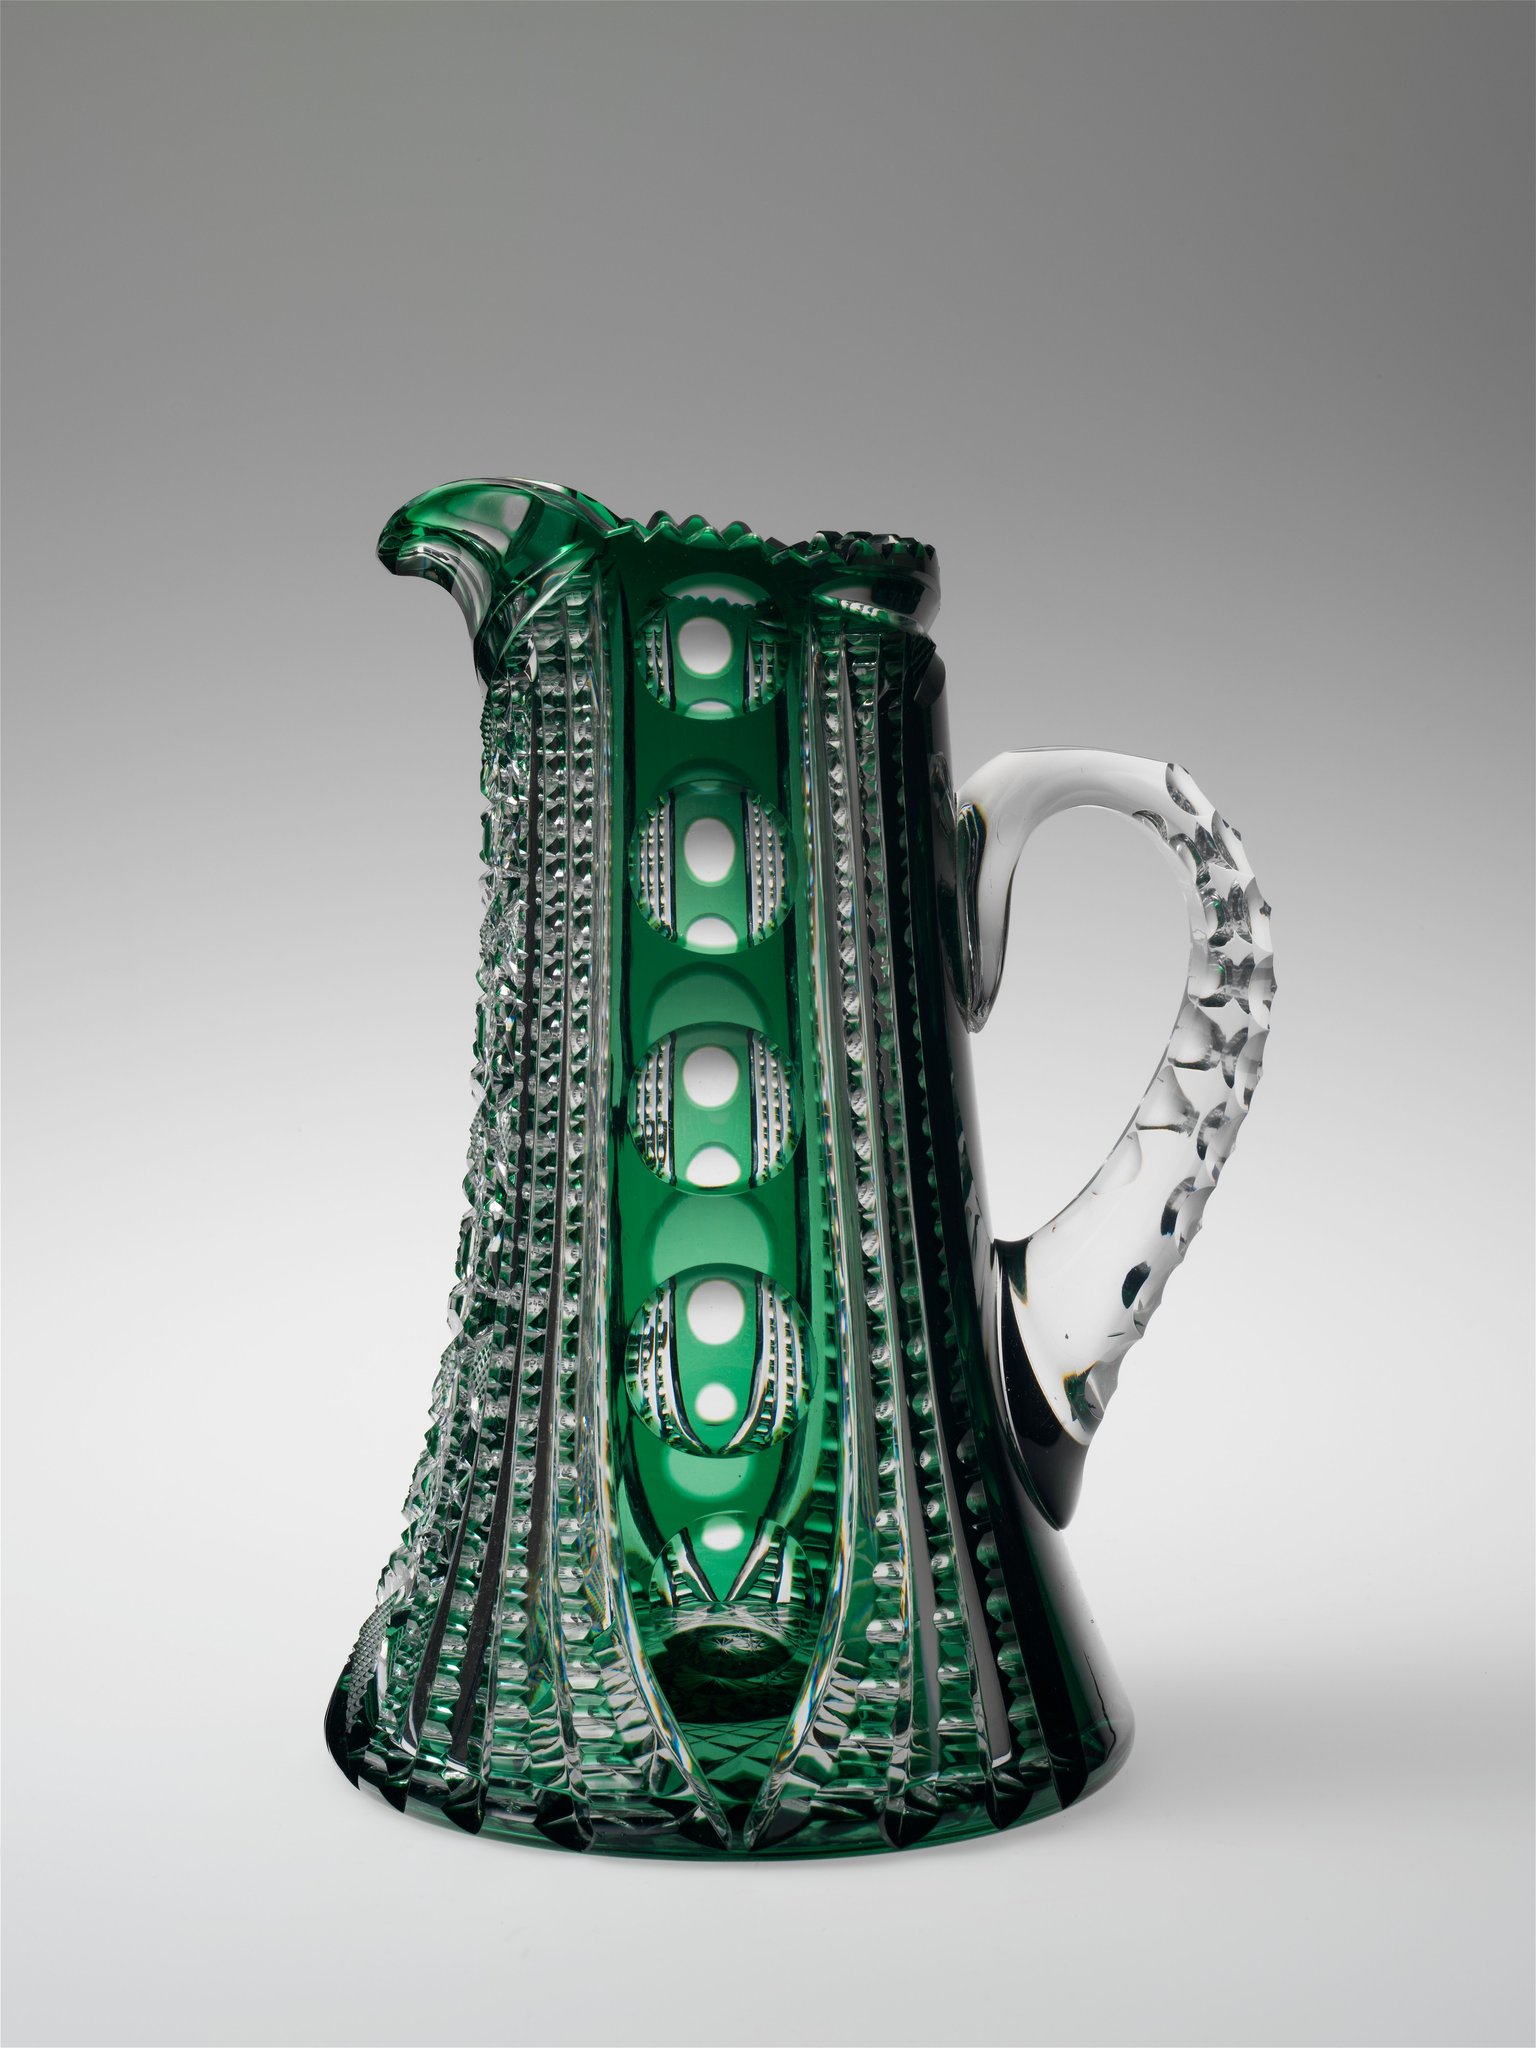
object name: pitcher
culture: american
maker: boston & sandwich glass company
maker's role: manufacturer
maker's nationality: american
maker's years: 1825-1888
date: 1843-1867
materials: glass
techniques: glassblowing, cutting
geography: united states